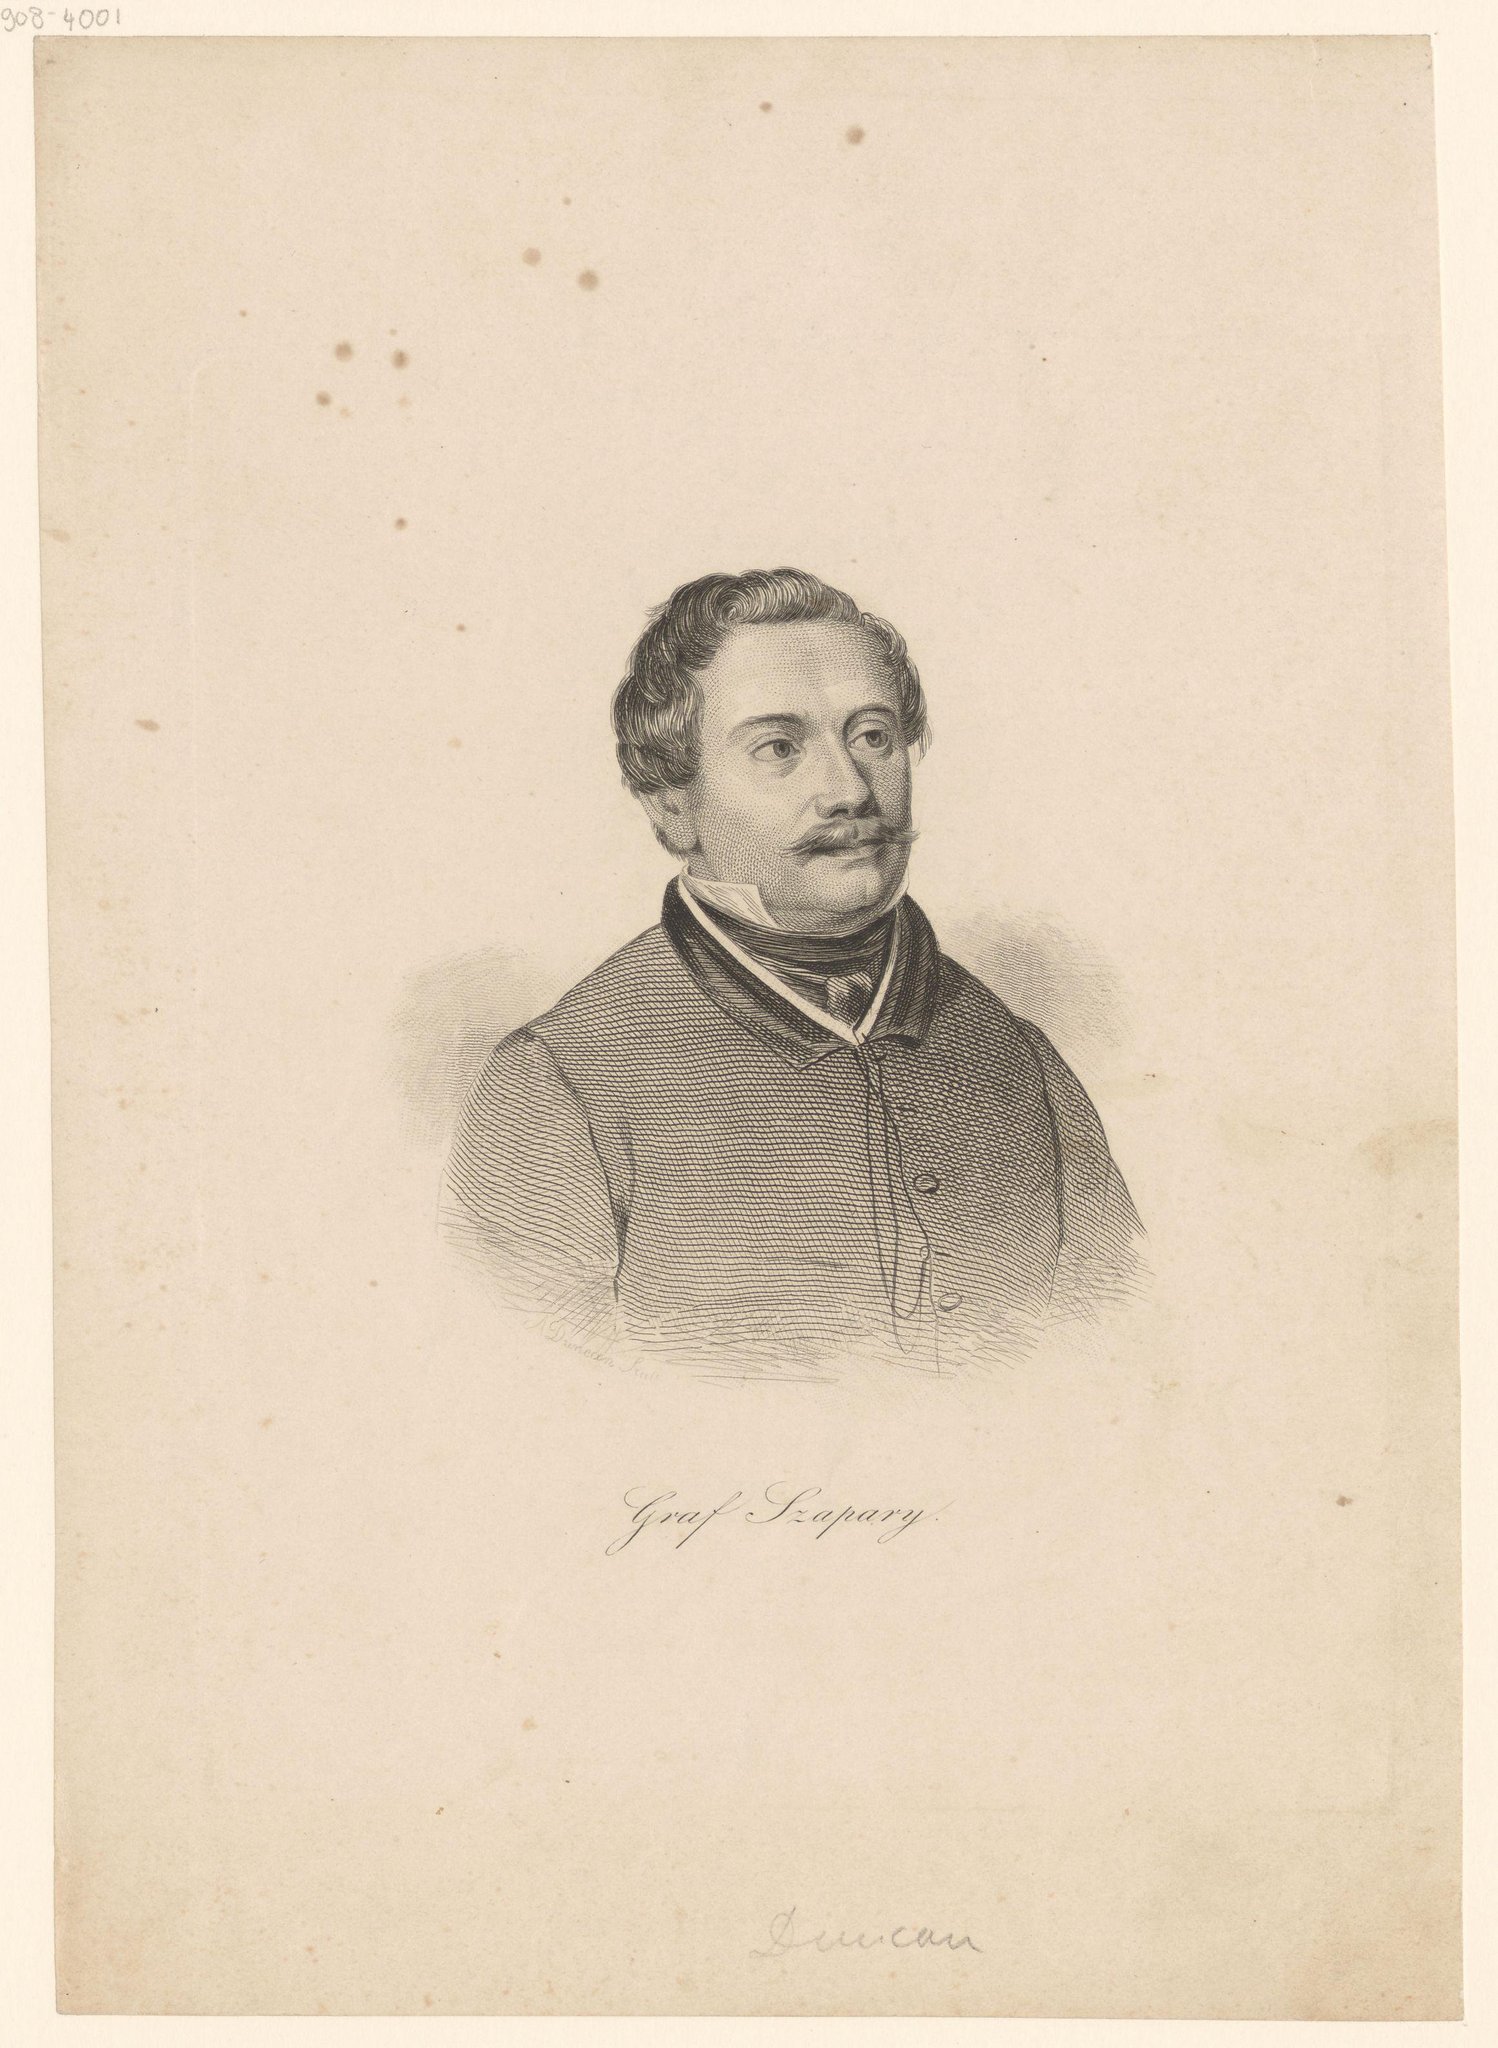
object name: print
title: Portret van Ferenc Szapary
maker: andrew duncan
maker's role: print maker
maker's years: 1795-1855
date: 1820-1895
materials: paper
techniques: engraving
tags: historical persons, biology (+ portrait of scholar, scientist)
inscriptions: collector's mark: Lugt 2228